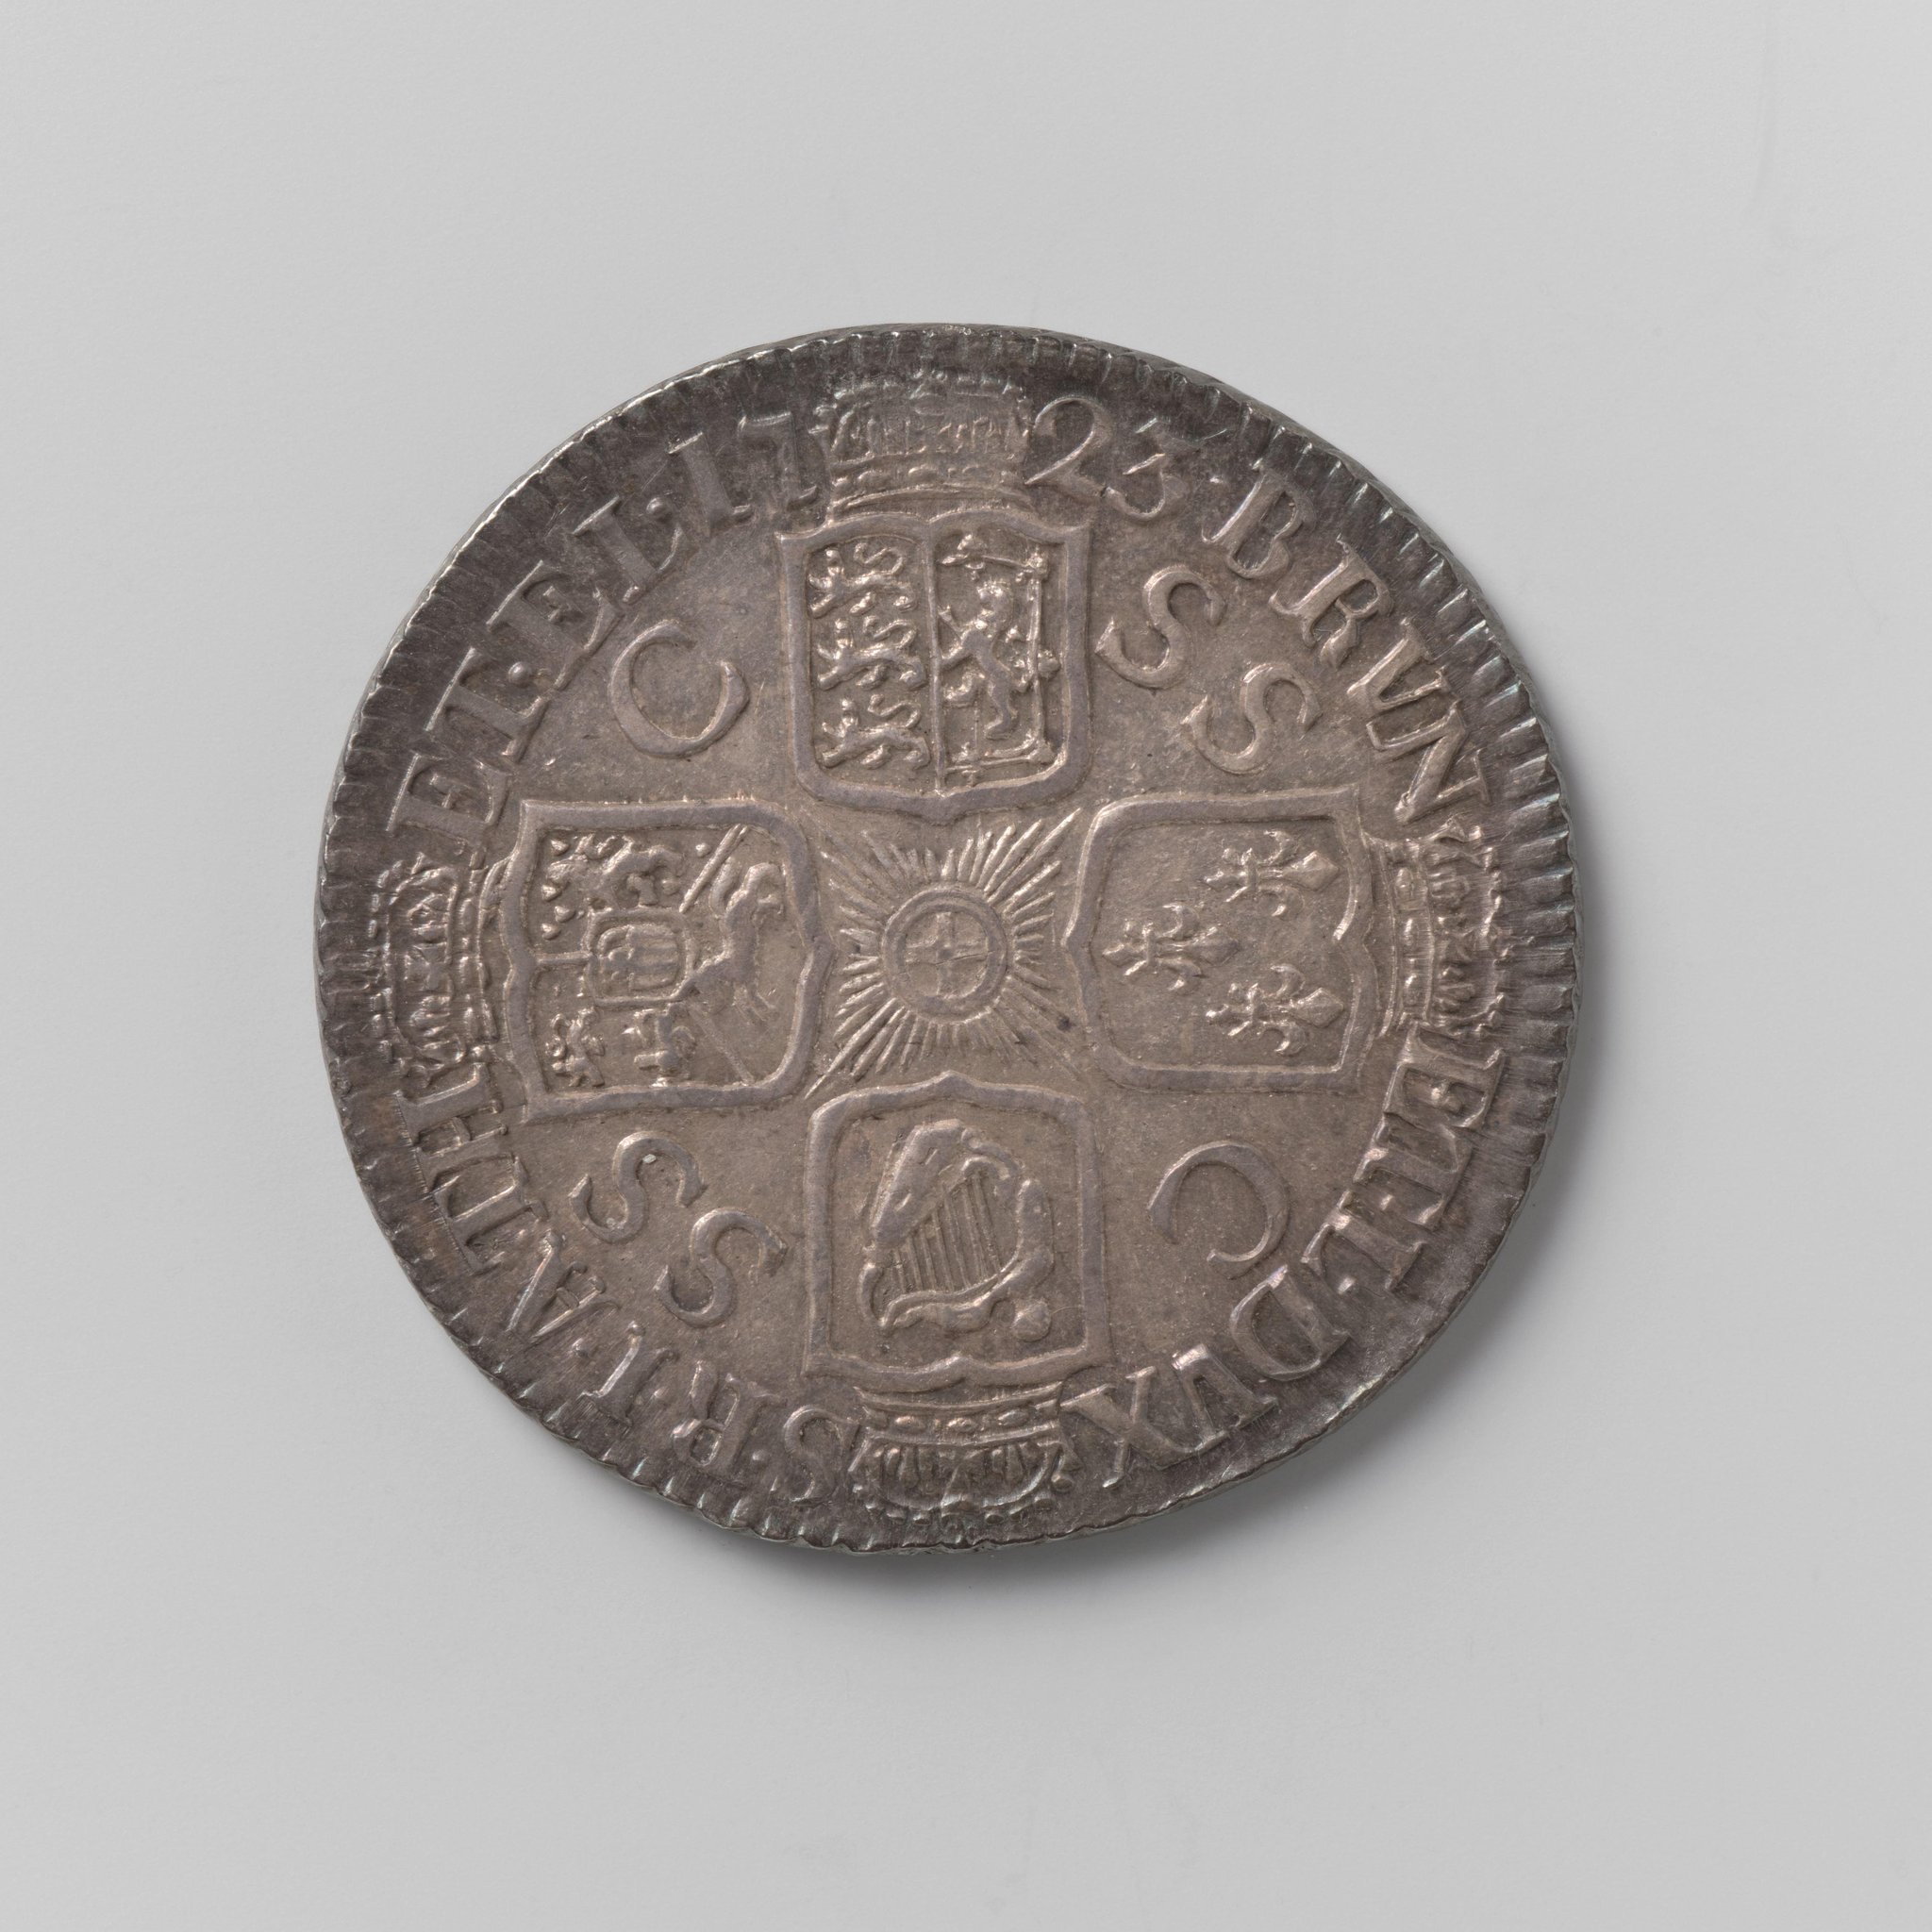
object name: coin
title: Engeland, George I, shilling, 1723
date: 1723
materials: silver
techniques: striking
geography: london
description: Zilveren munt. Voorzijde: gelauwerd borstbeeld van de koning naar rechts. Keerzijde: rondom kruis binnen cirkel, waaromheen stralen, vier in kruisvorm geplaatste gekroonde wapenschilden. In de hoeken letters SS en C [=South Sea Company]. Jaartal bovenaan in omschrift. Kabelrand.